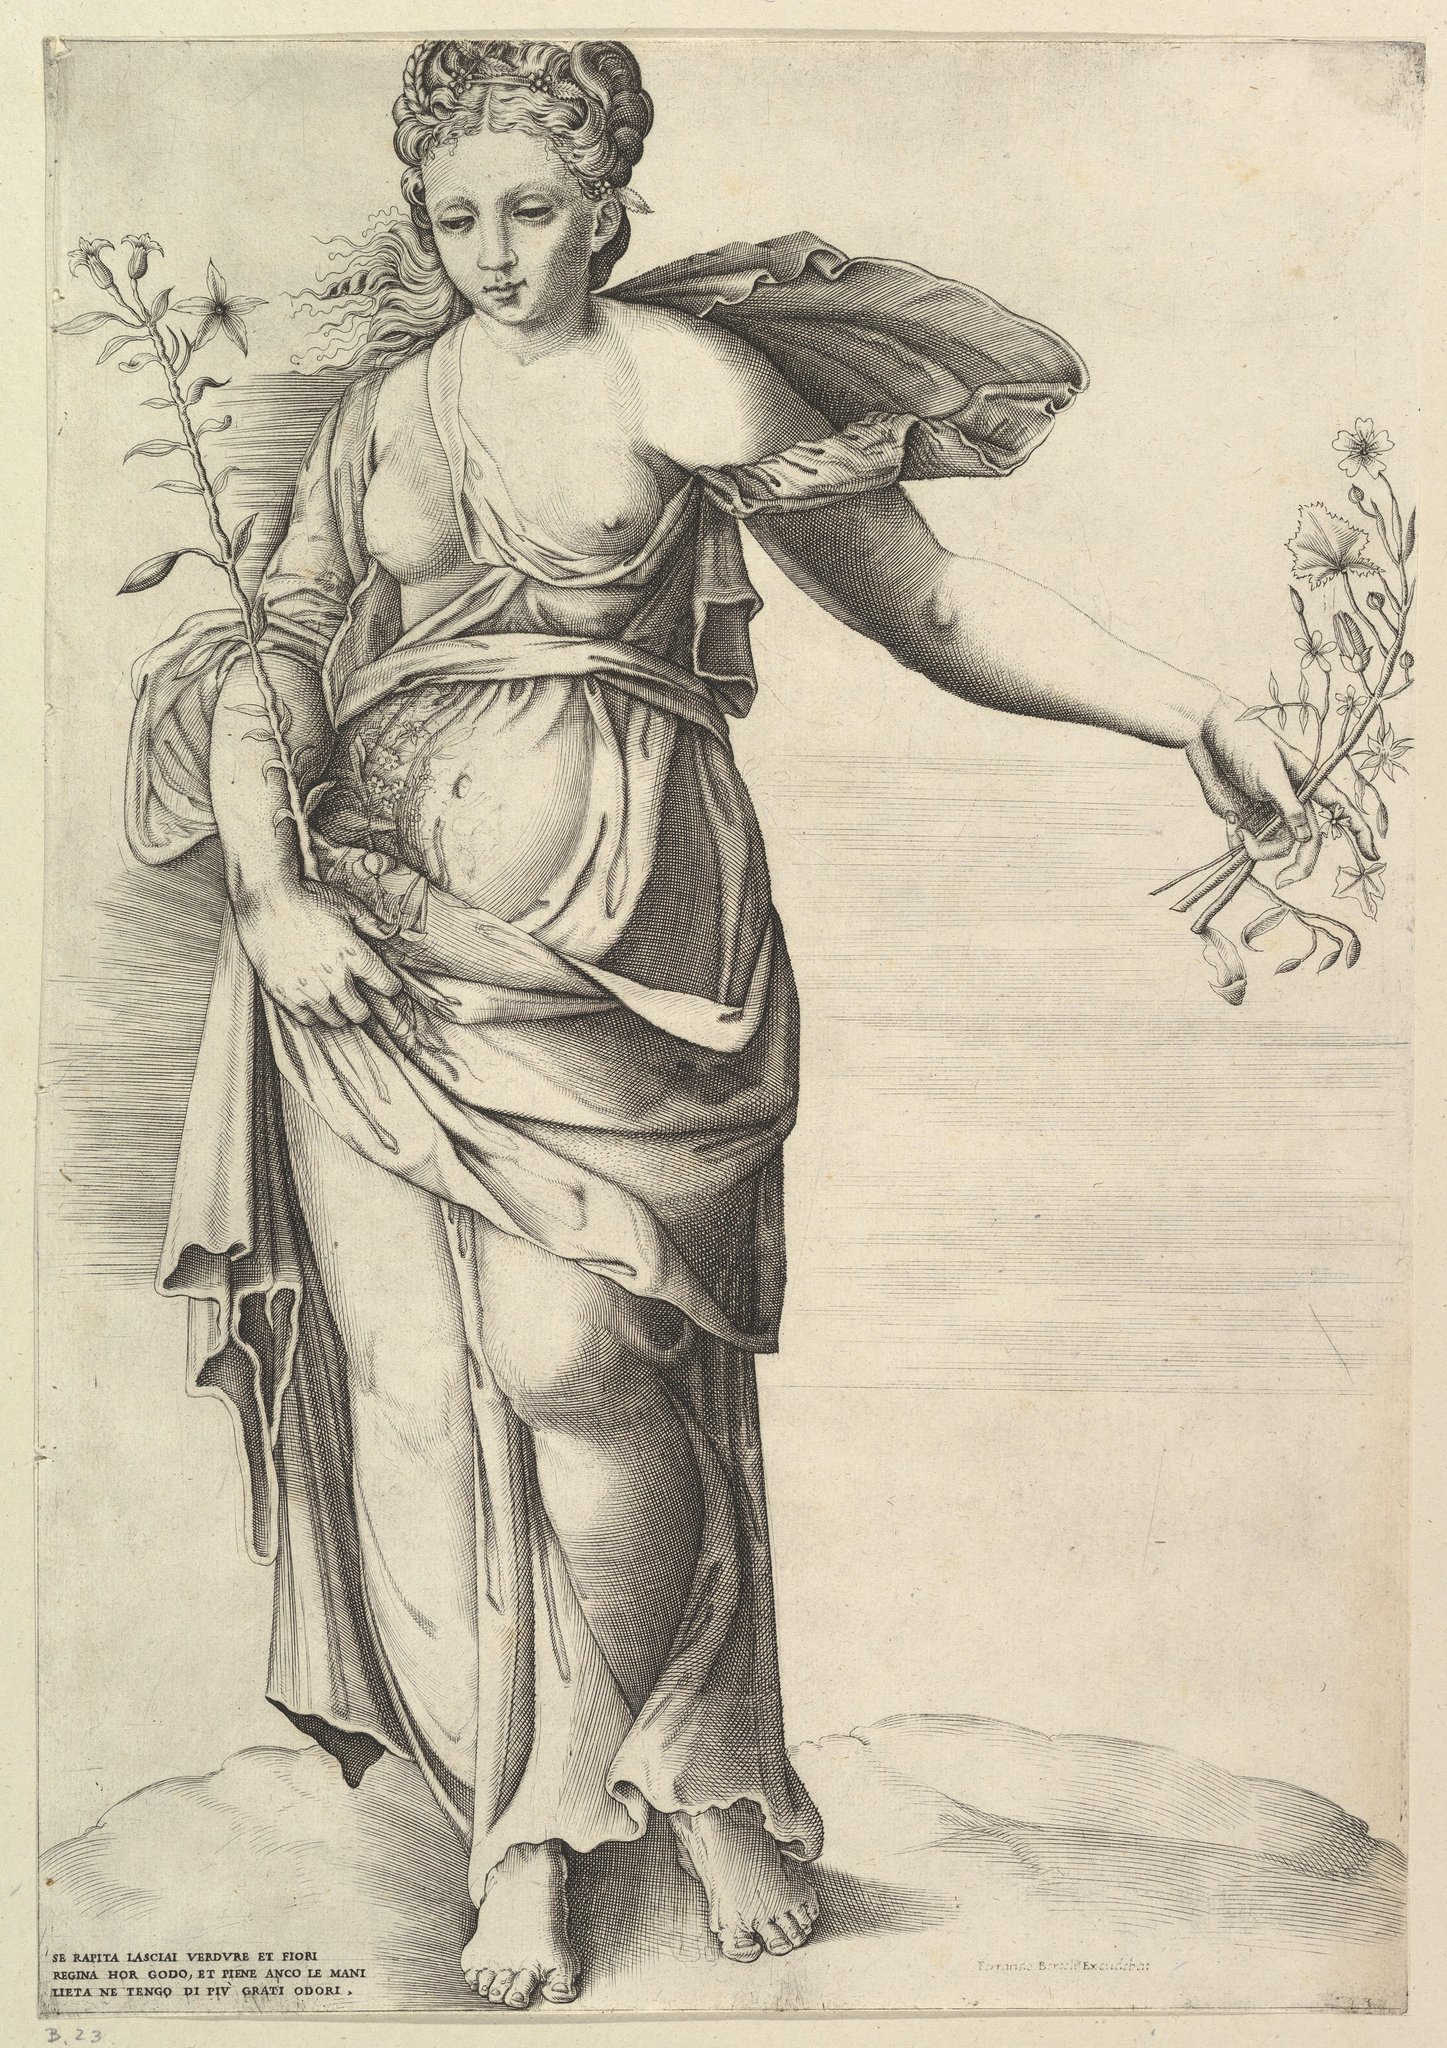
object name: print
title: Flora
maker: anonymous, italian, second half of the 16th century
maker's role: artist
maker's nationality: italian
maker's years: 1550-1600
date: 1560-1570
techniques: engraving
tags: female nudes,flowers